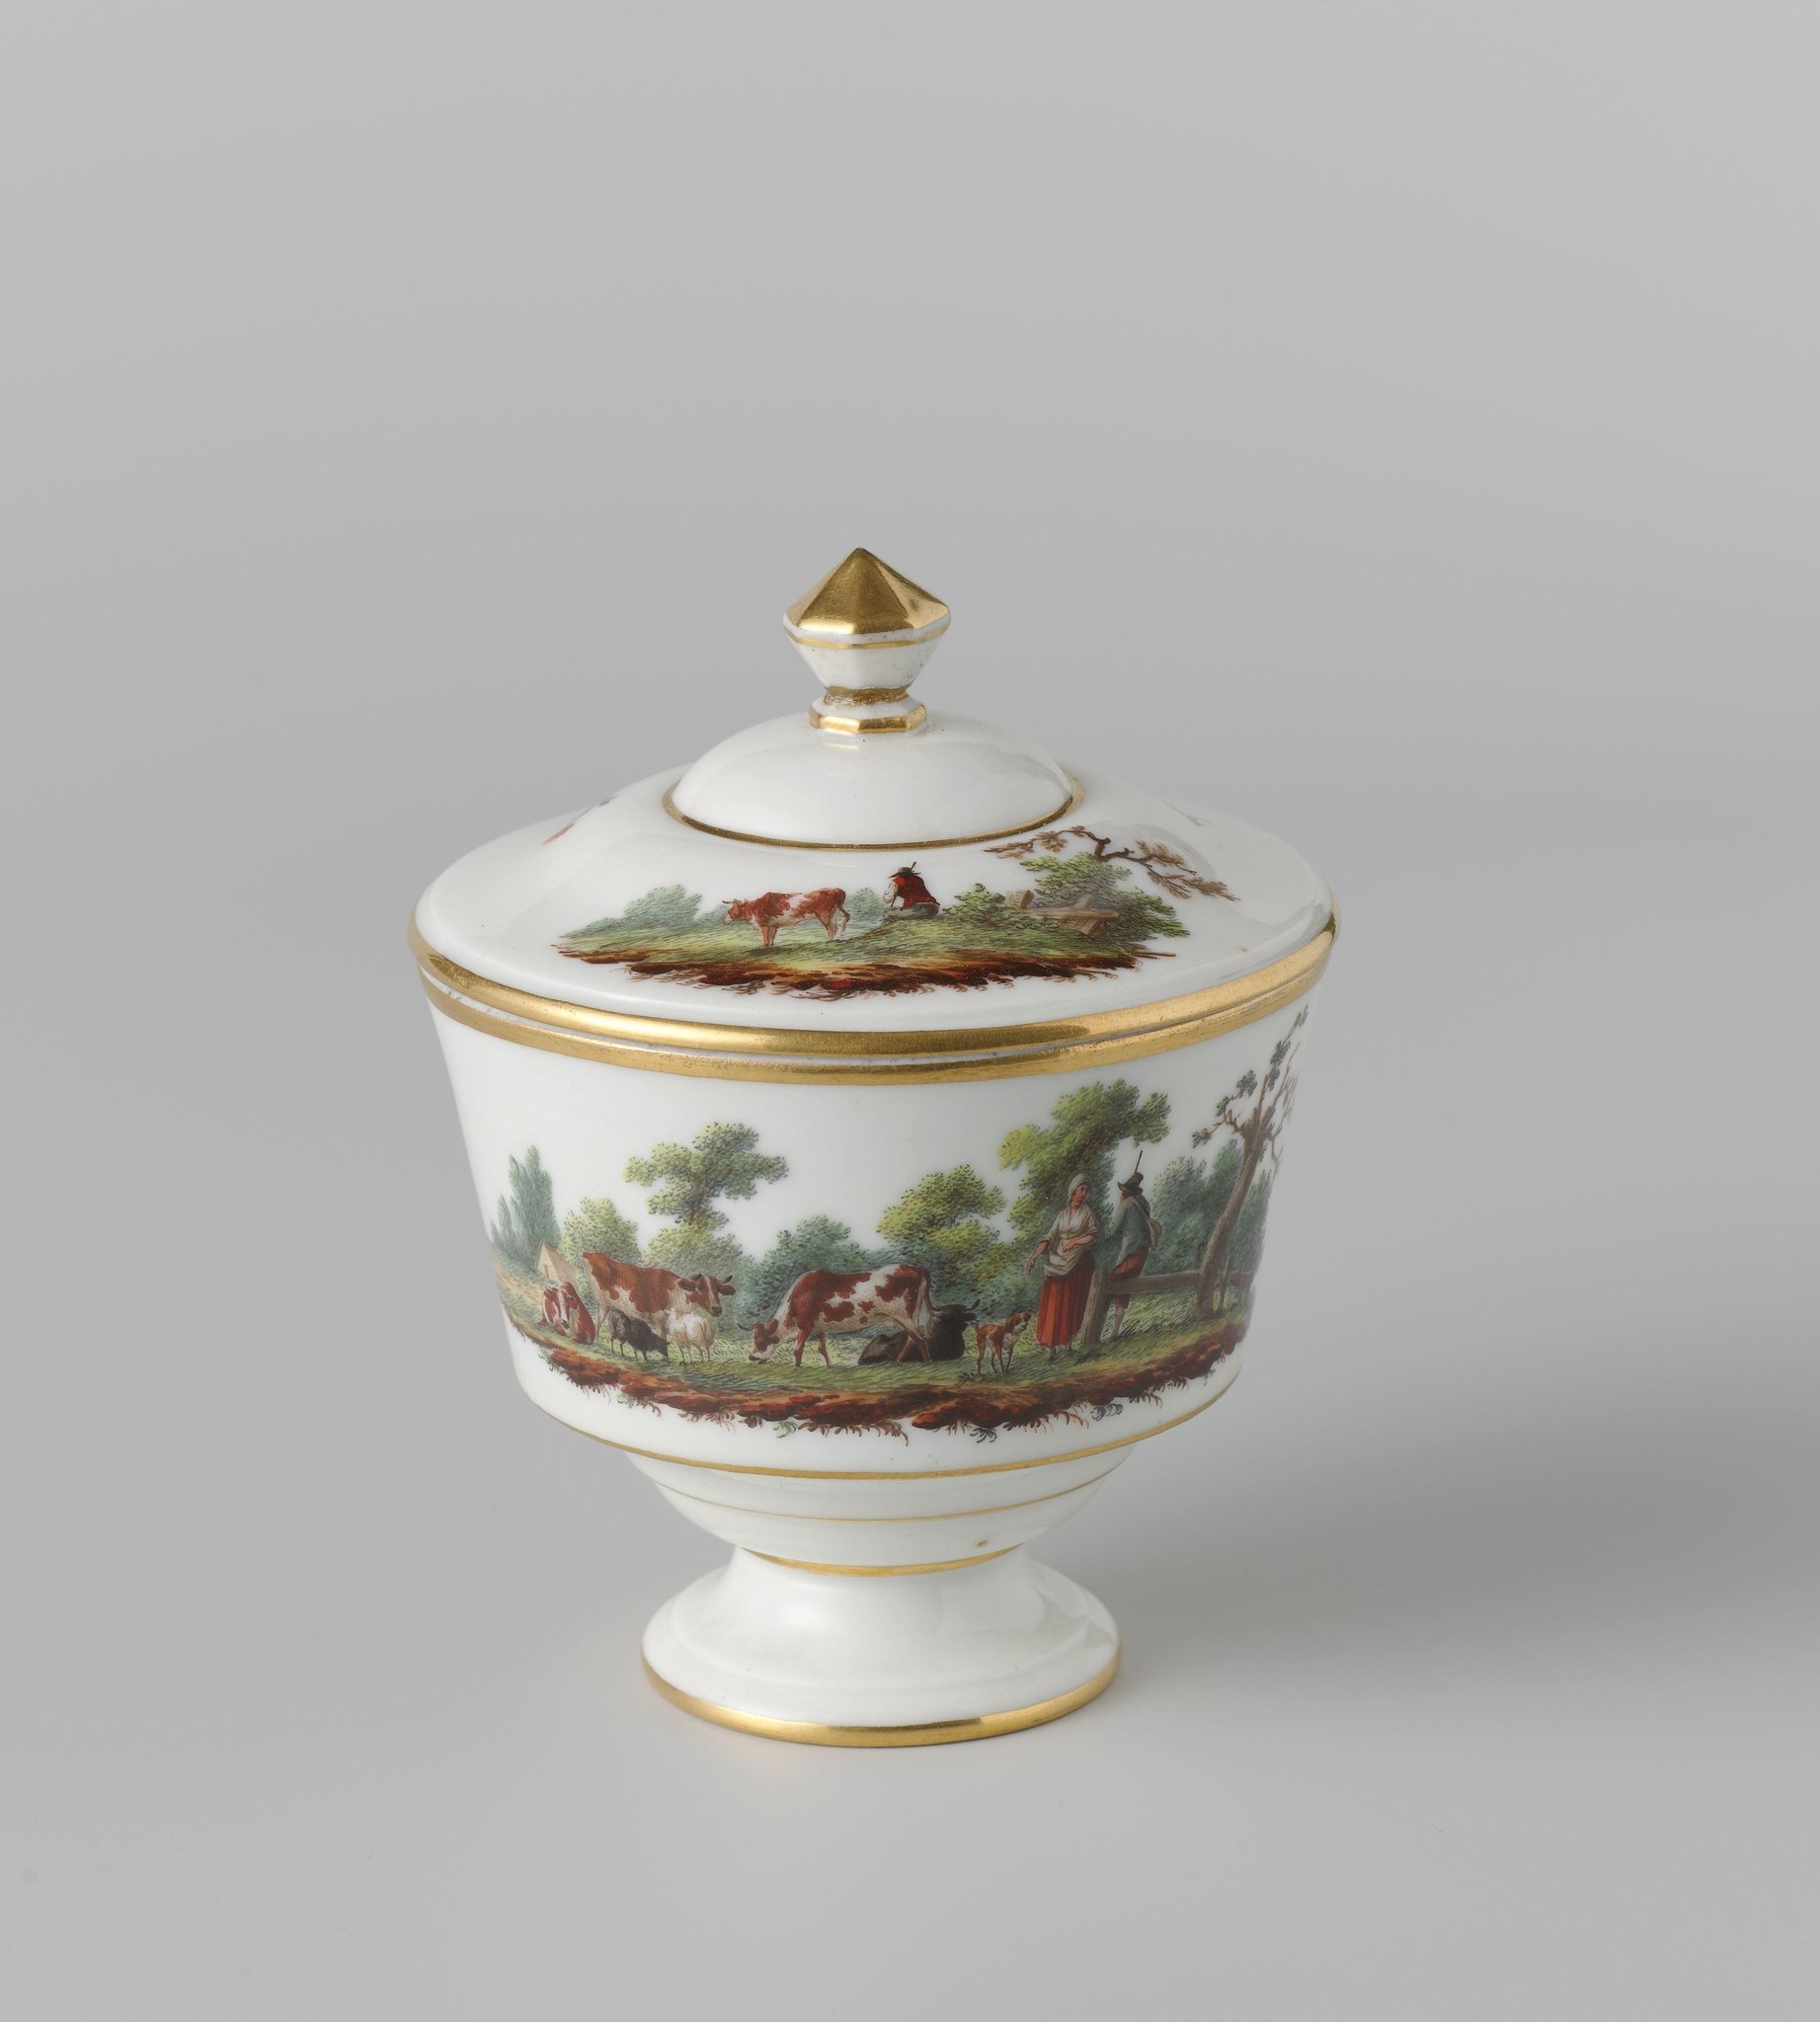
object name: suikervaas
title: Suikervaas, beschilderd met een landschap met vee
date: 1809-1814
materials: porcelain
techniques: painted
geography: nieuwer-amstel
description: Suikervaas, beschilderd met landschap met vee met boer en boerin. Strooibloemen en gouden randen. Gemerkt: Amstel in blauw.